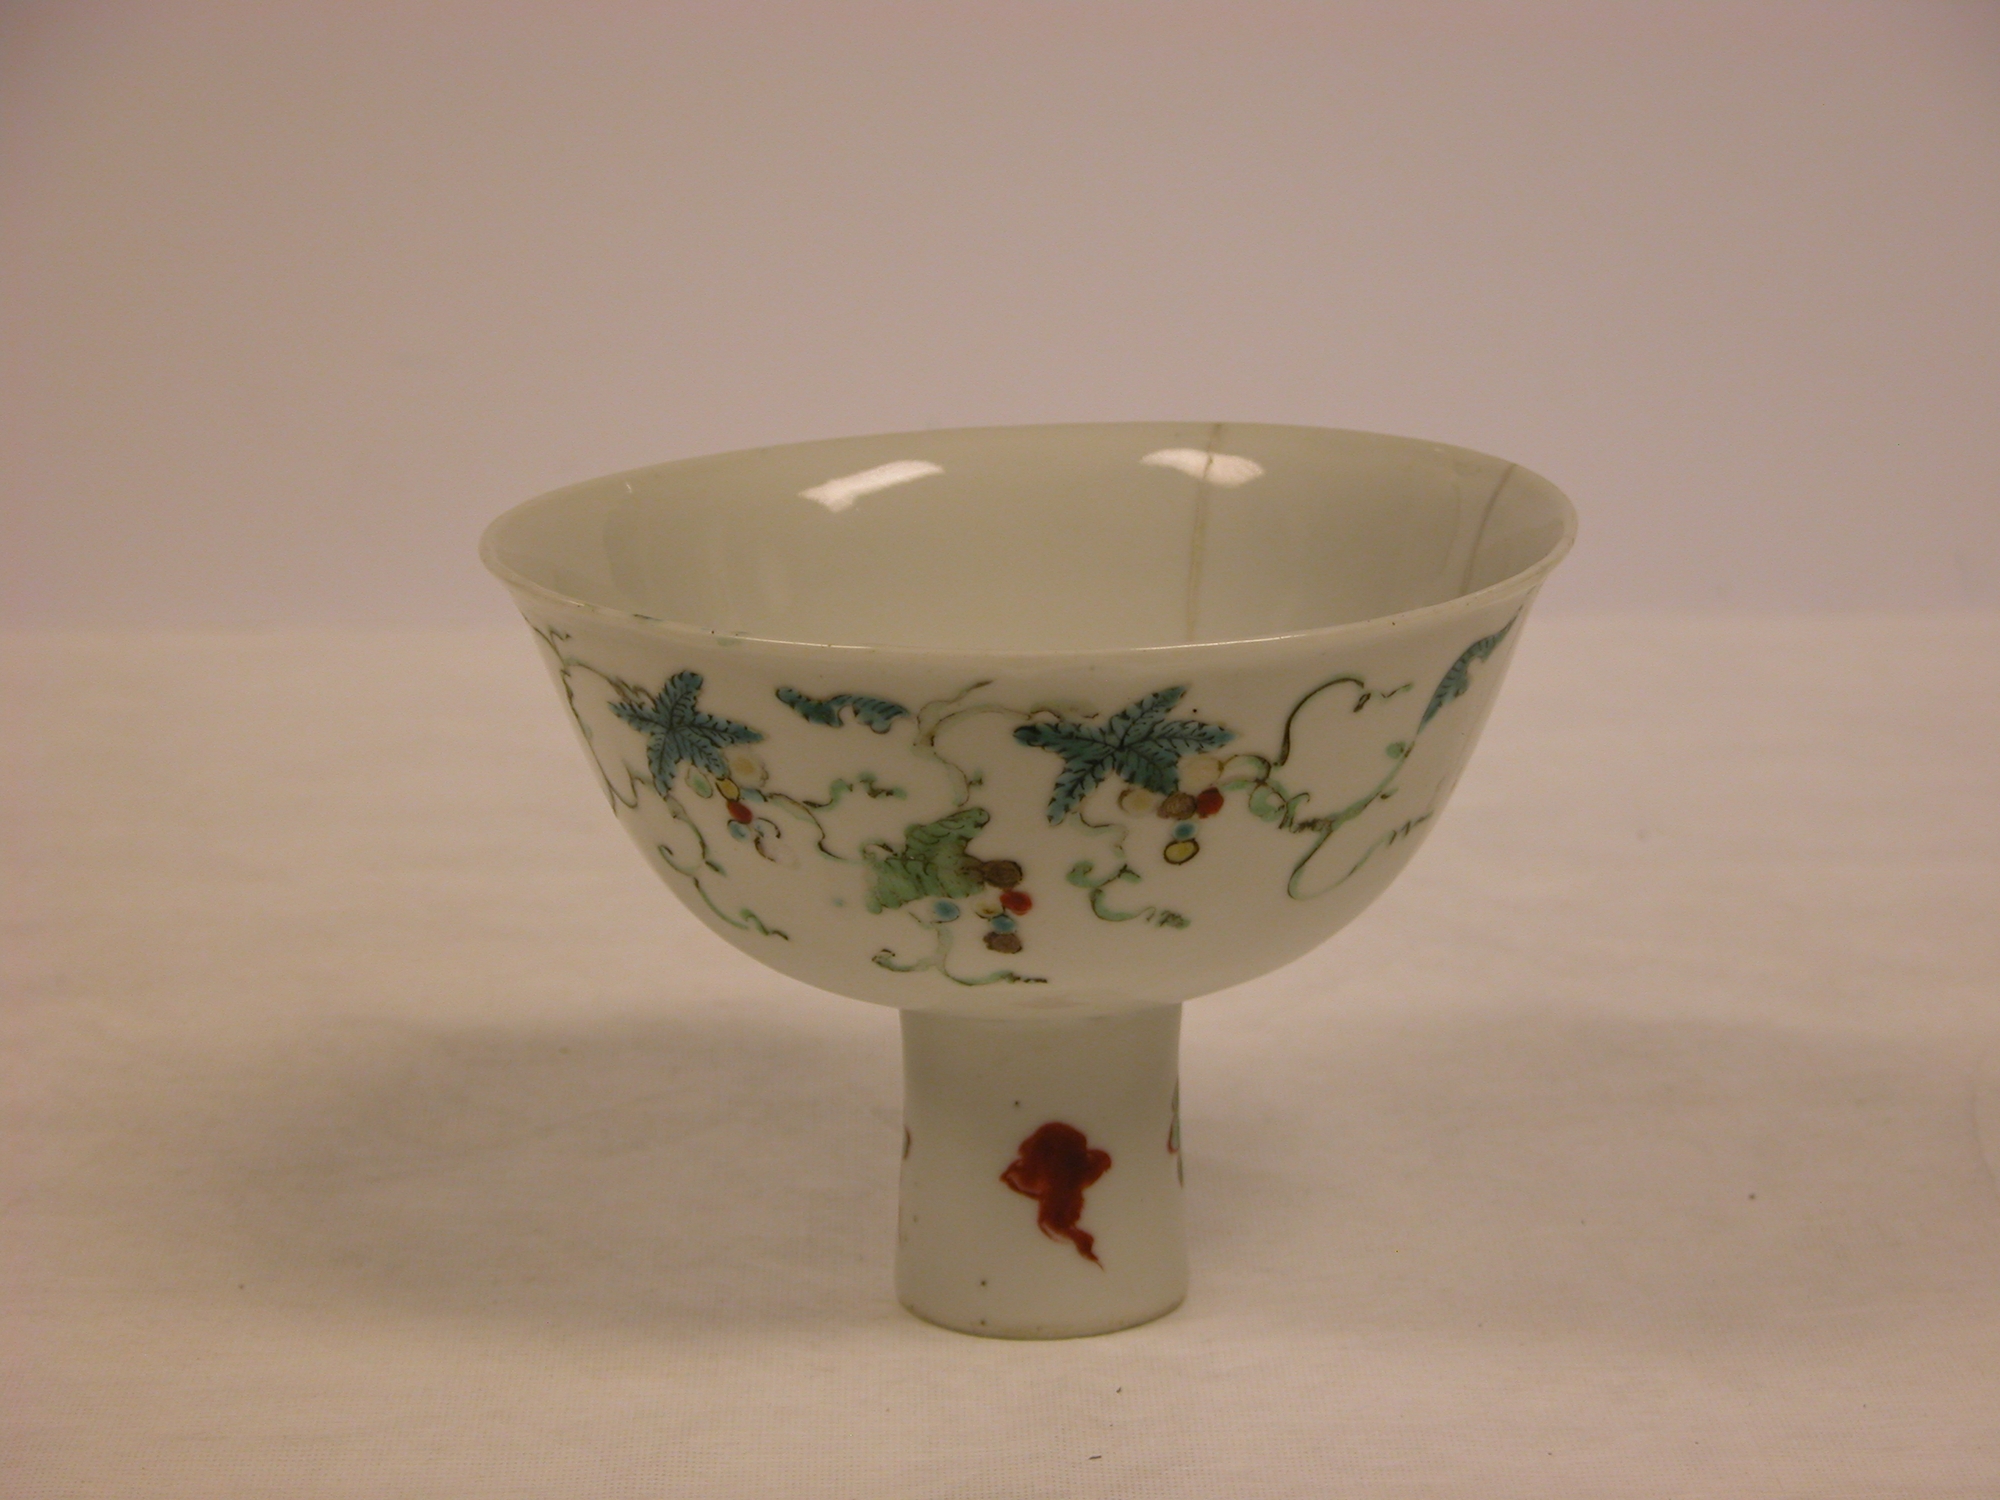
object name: stem bowl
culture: chinese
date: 1501-1533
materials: enamel, porcelain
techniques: overglaze, painting, polychrome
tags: leaves